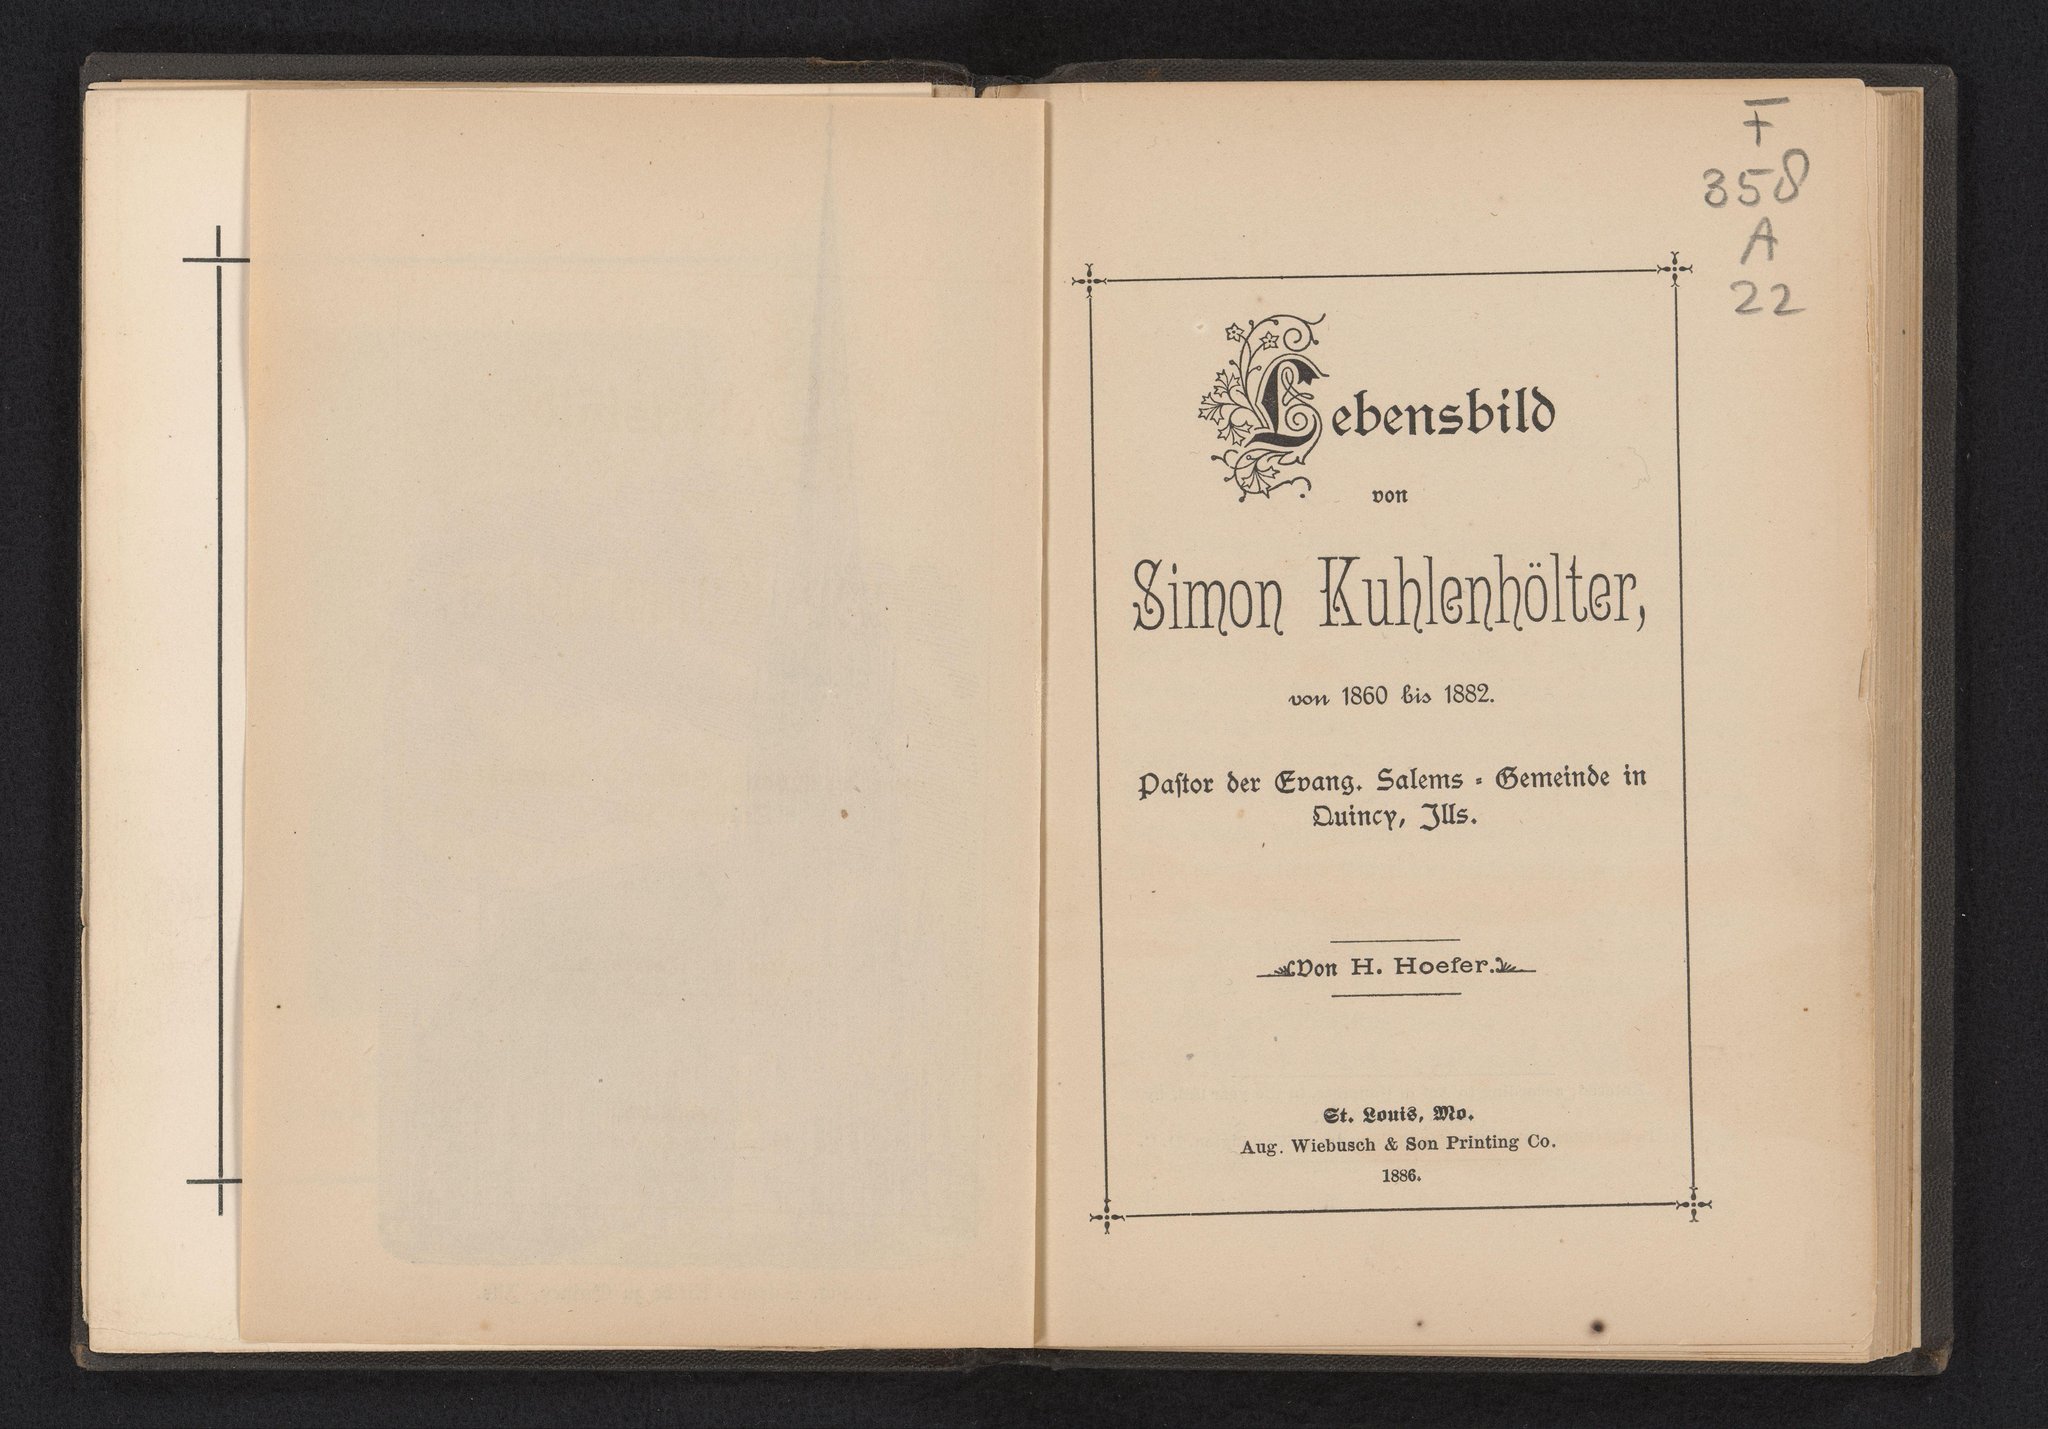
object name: book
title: Lebensbild von Simon Kuhlenhölter von 1860 bis 1882, Pastor der Evang. Salems Gemeinde in Quincy, Ills. / von H. Hoefer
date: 1886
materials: cardboard, paper, photographic support, textile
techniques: albumen print, printing, engraving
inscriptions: annotation: ‘AUG/ 1991’